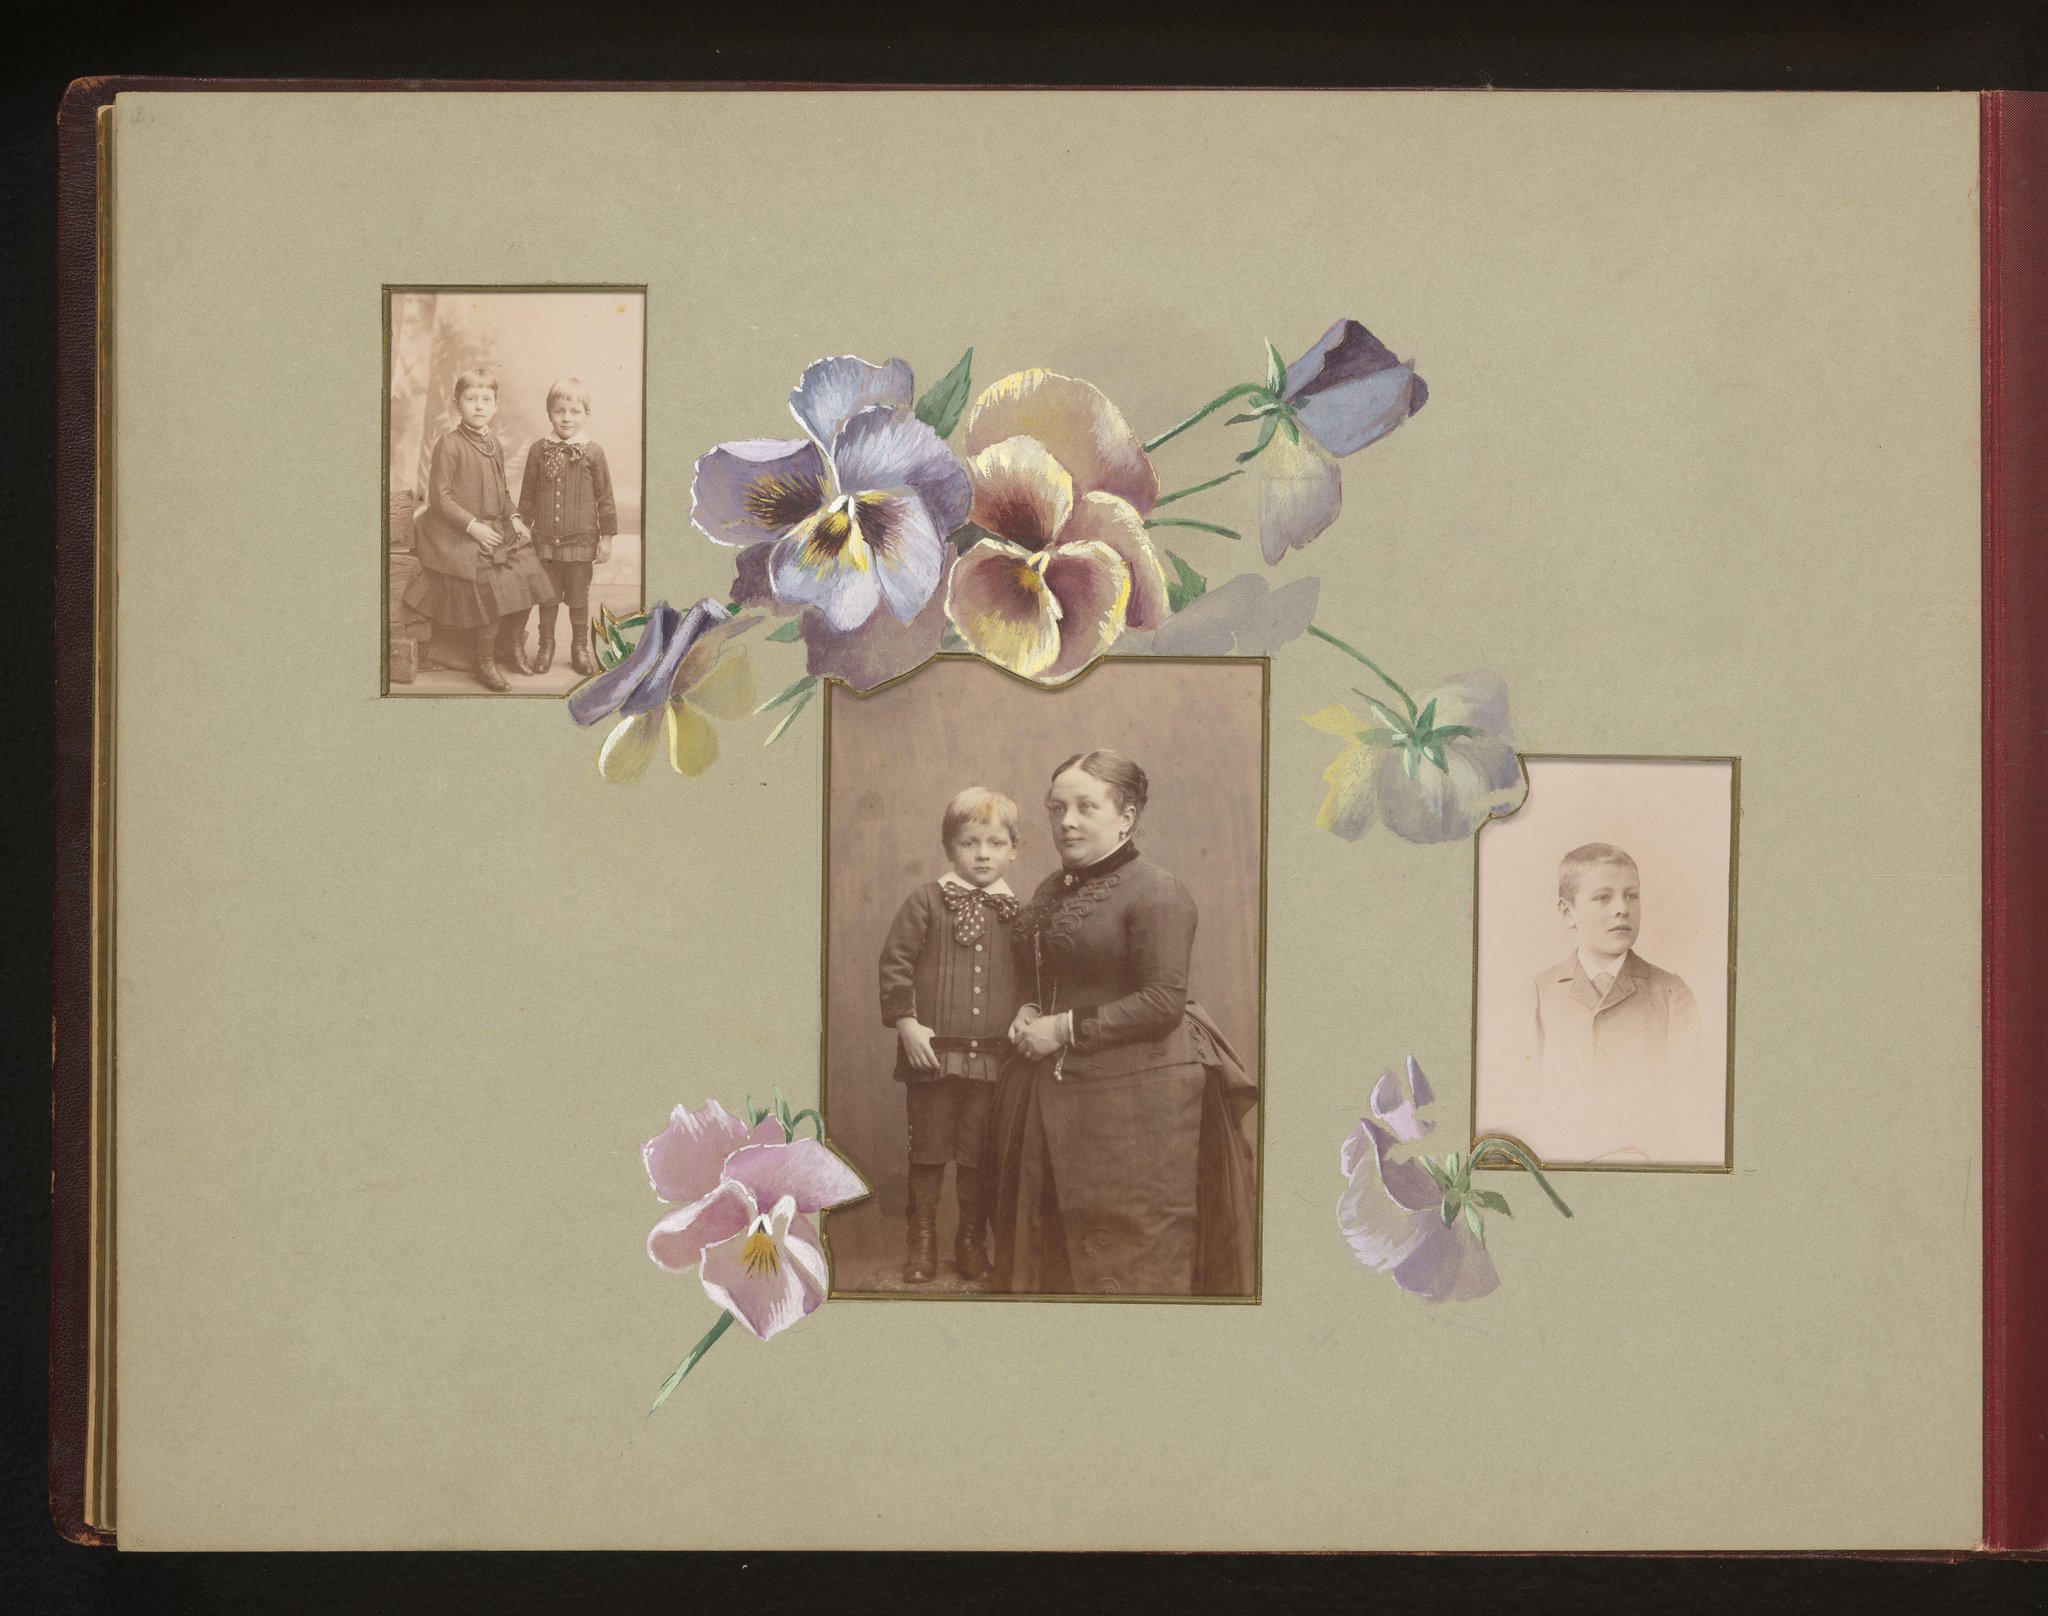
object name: album leaf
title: Portret van twee kinderen, Portret van een vrouw en een kind en Portret van een jongen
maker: Anonymous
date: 1872-1897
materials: paint, photographic support, watercolor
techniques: albumen print, brush, hand coloring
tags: adult woman, boy (child between toddler and youth), child